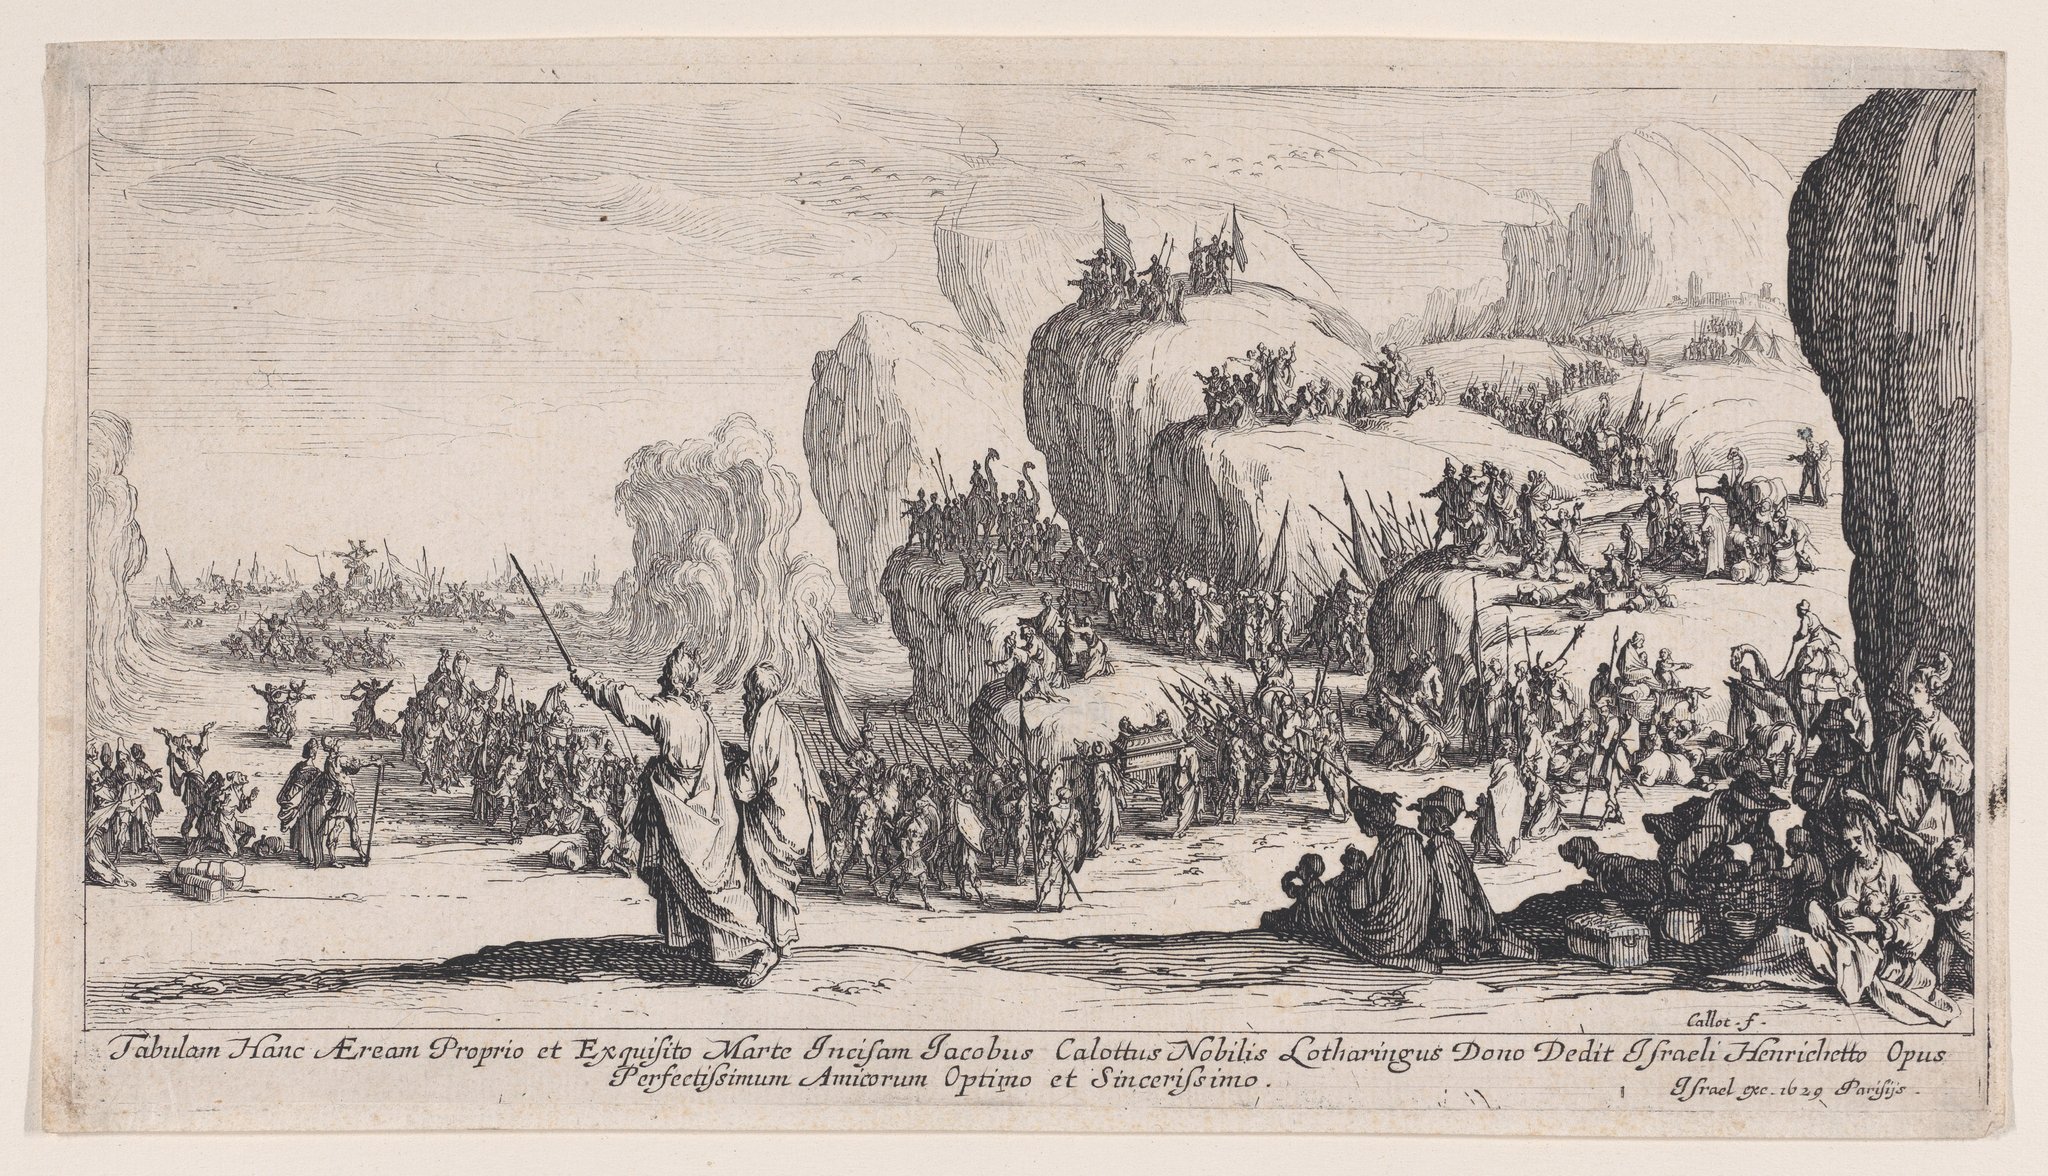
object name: print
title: Le Passage de la Mer Rouge (The Passage of the Red Sea)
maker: jacques callot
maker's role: artist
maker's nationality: french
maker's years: 1592-1635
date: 1629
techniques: etching